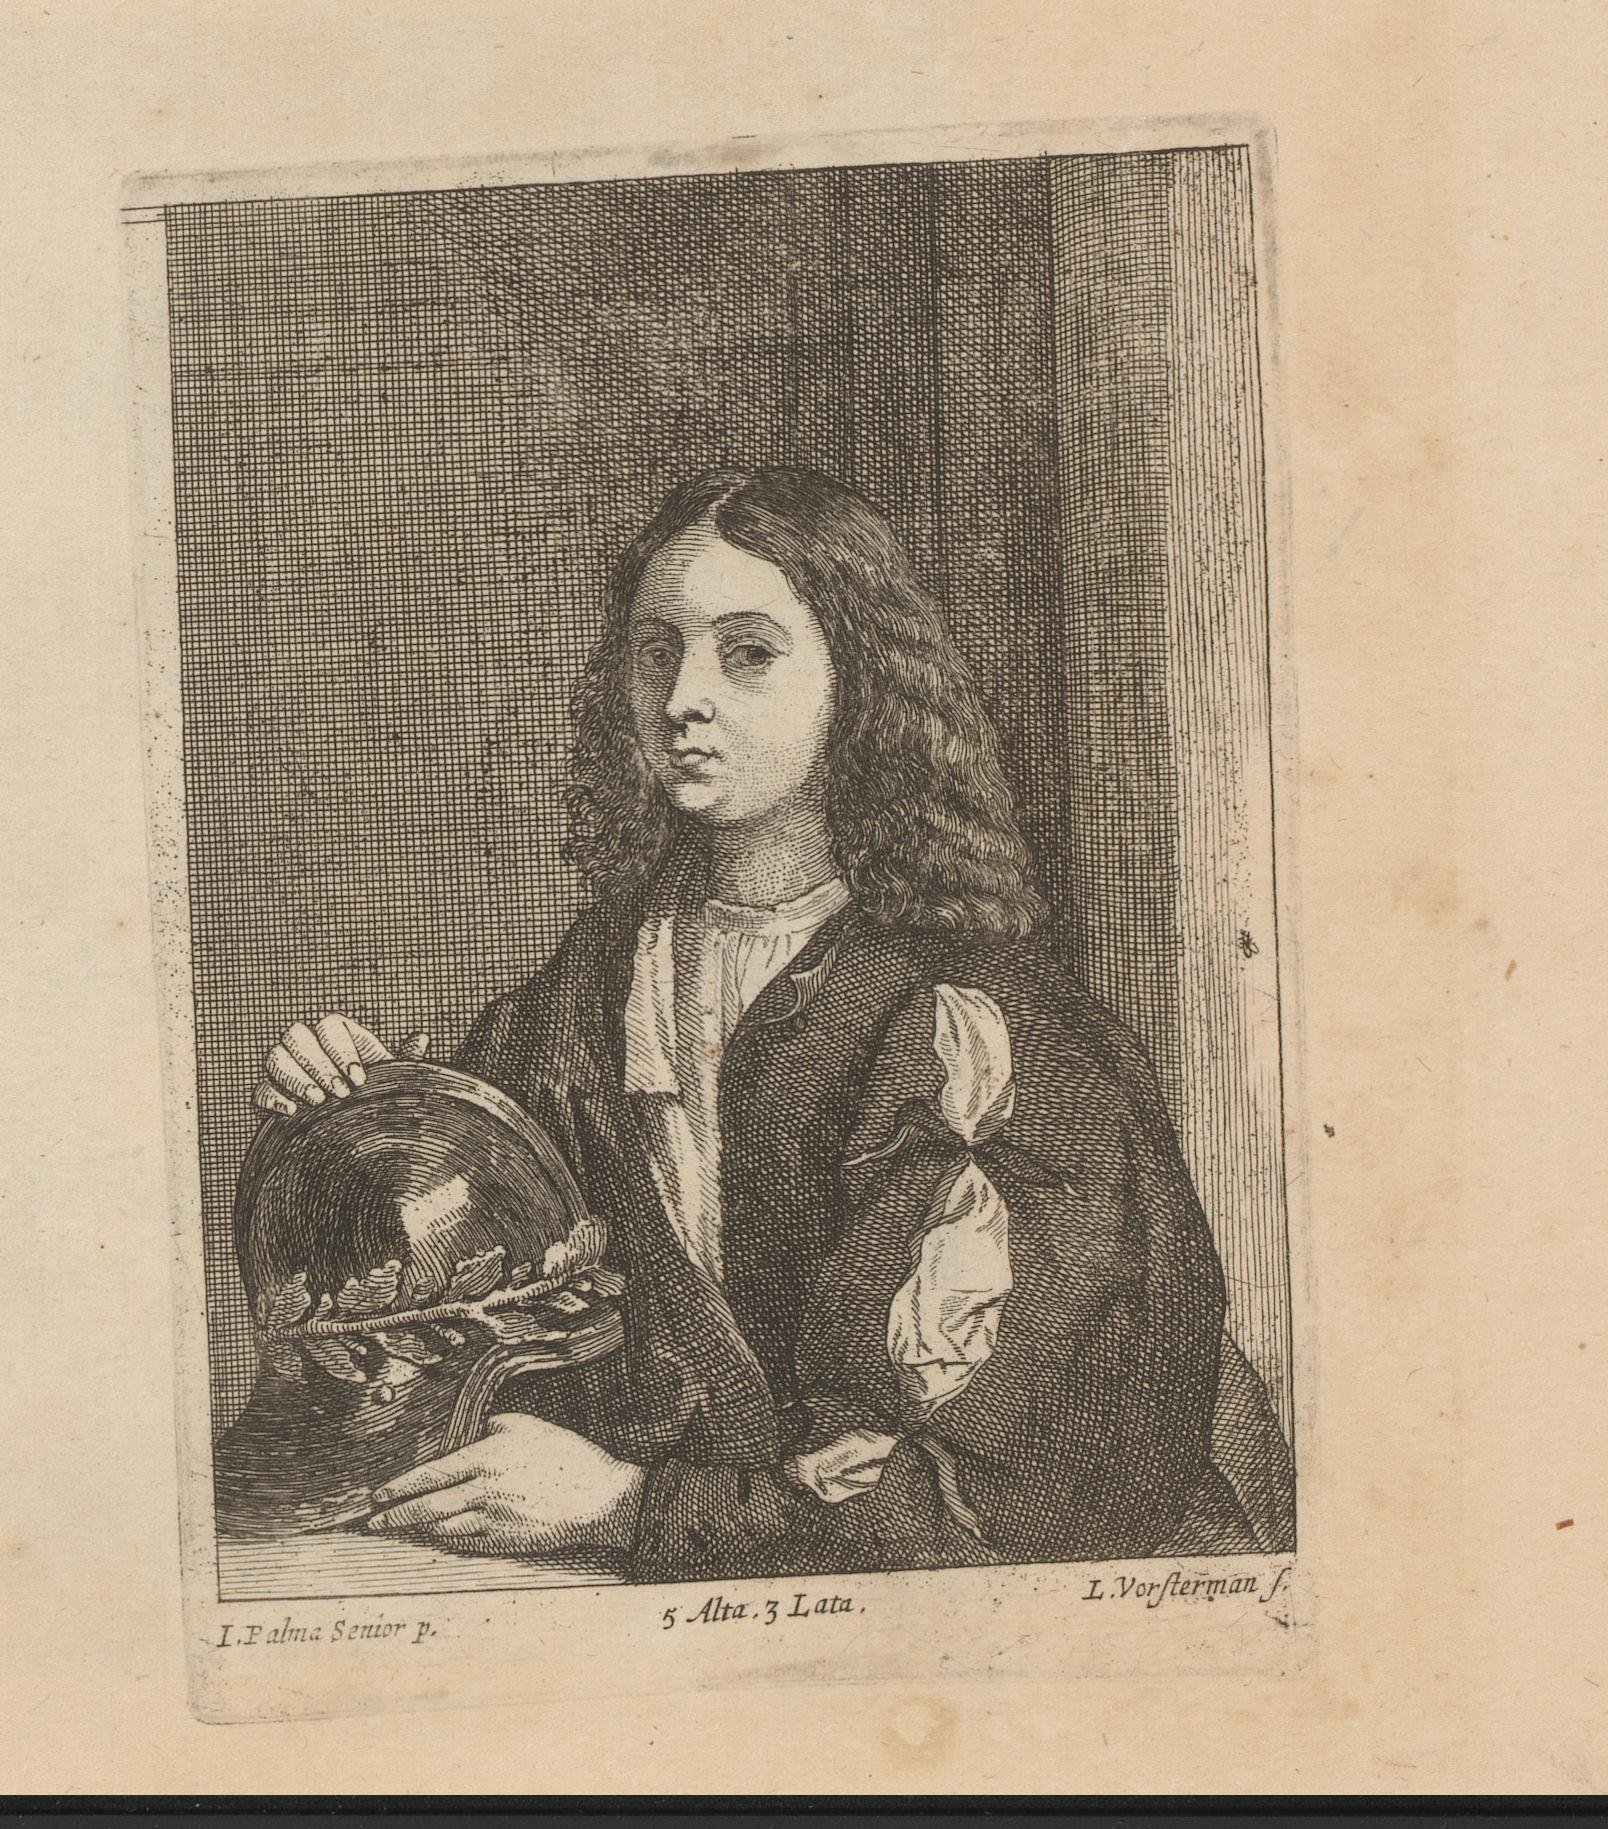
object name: print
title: Portret van Francesco Maria I della Rovere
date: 1660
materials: paper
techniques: etching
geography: antwerp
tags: francesco maria i della rovere (duke of urbino), helmet, historical persons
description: De prent is vervaardigd naar het aan Giorgione toegeschreven schilderij dat zich in de collectie van het Kunsthistorisches Museum te Wenen bevindt (inventarisnummer GG_10). David Teniers heeft waarschijnlijk van alle schilderijen uit de collectie van Leopold Willem van Oostenrijk een olieverfstudie op doek of paneel vervaardigd (zgn. pasticcio), die als voorbeeld voor de prentmakers diende. Het is niet altijd duidelijk of de pasticci door hem zijn gemaakt of door zijn atelier. Niet alle pasticci zijn overgeleverd.